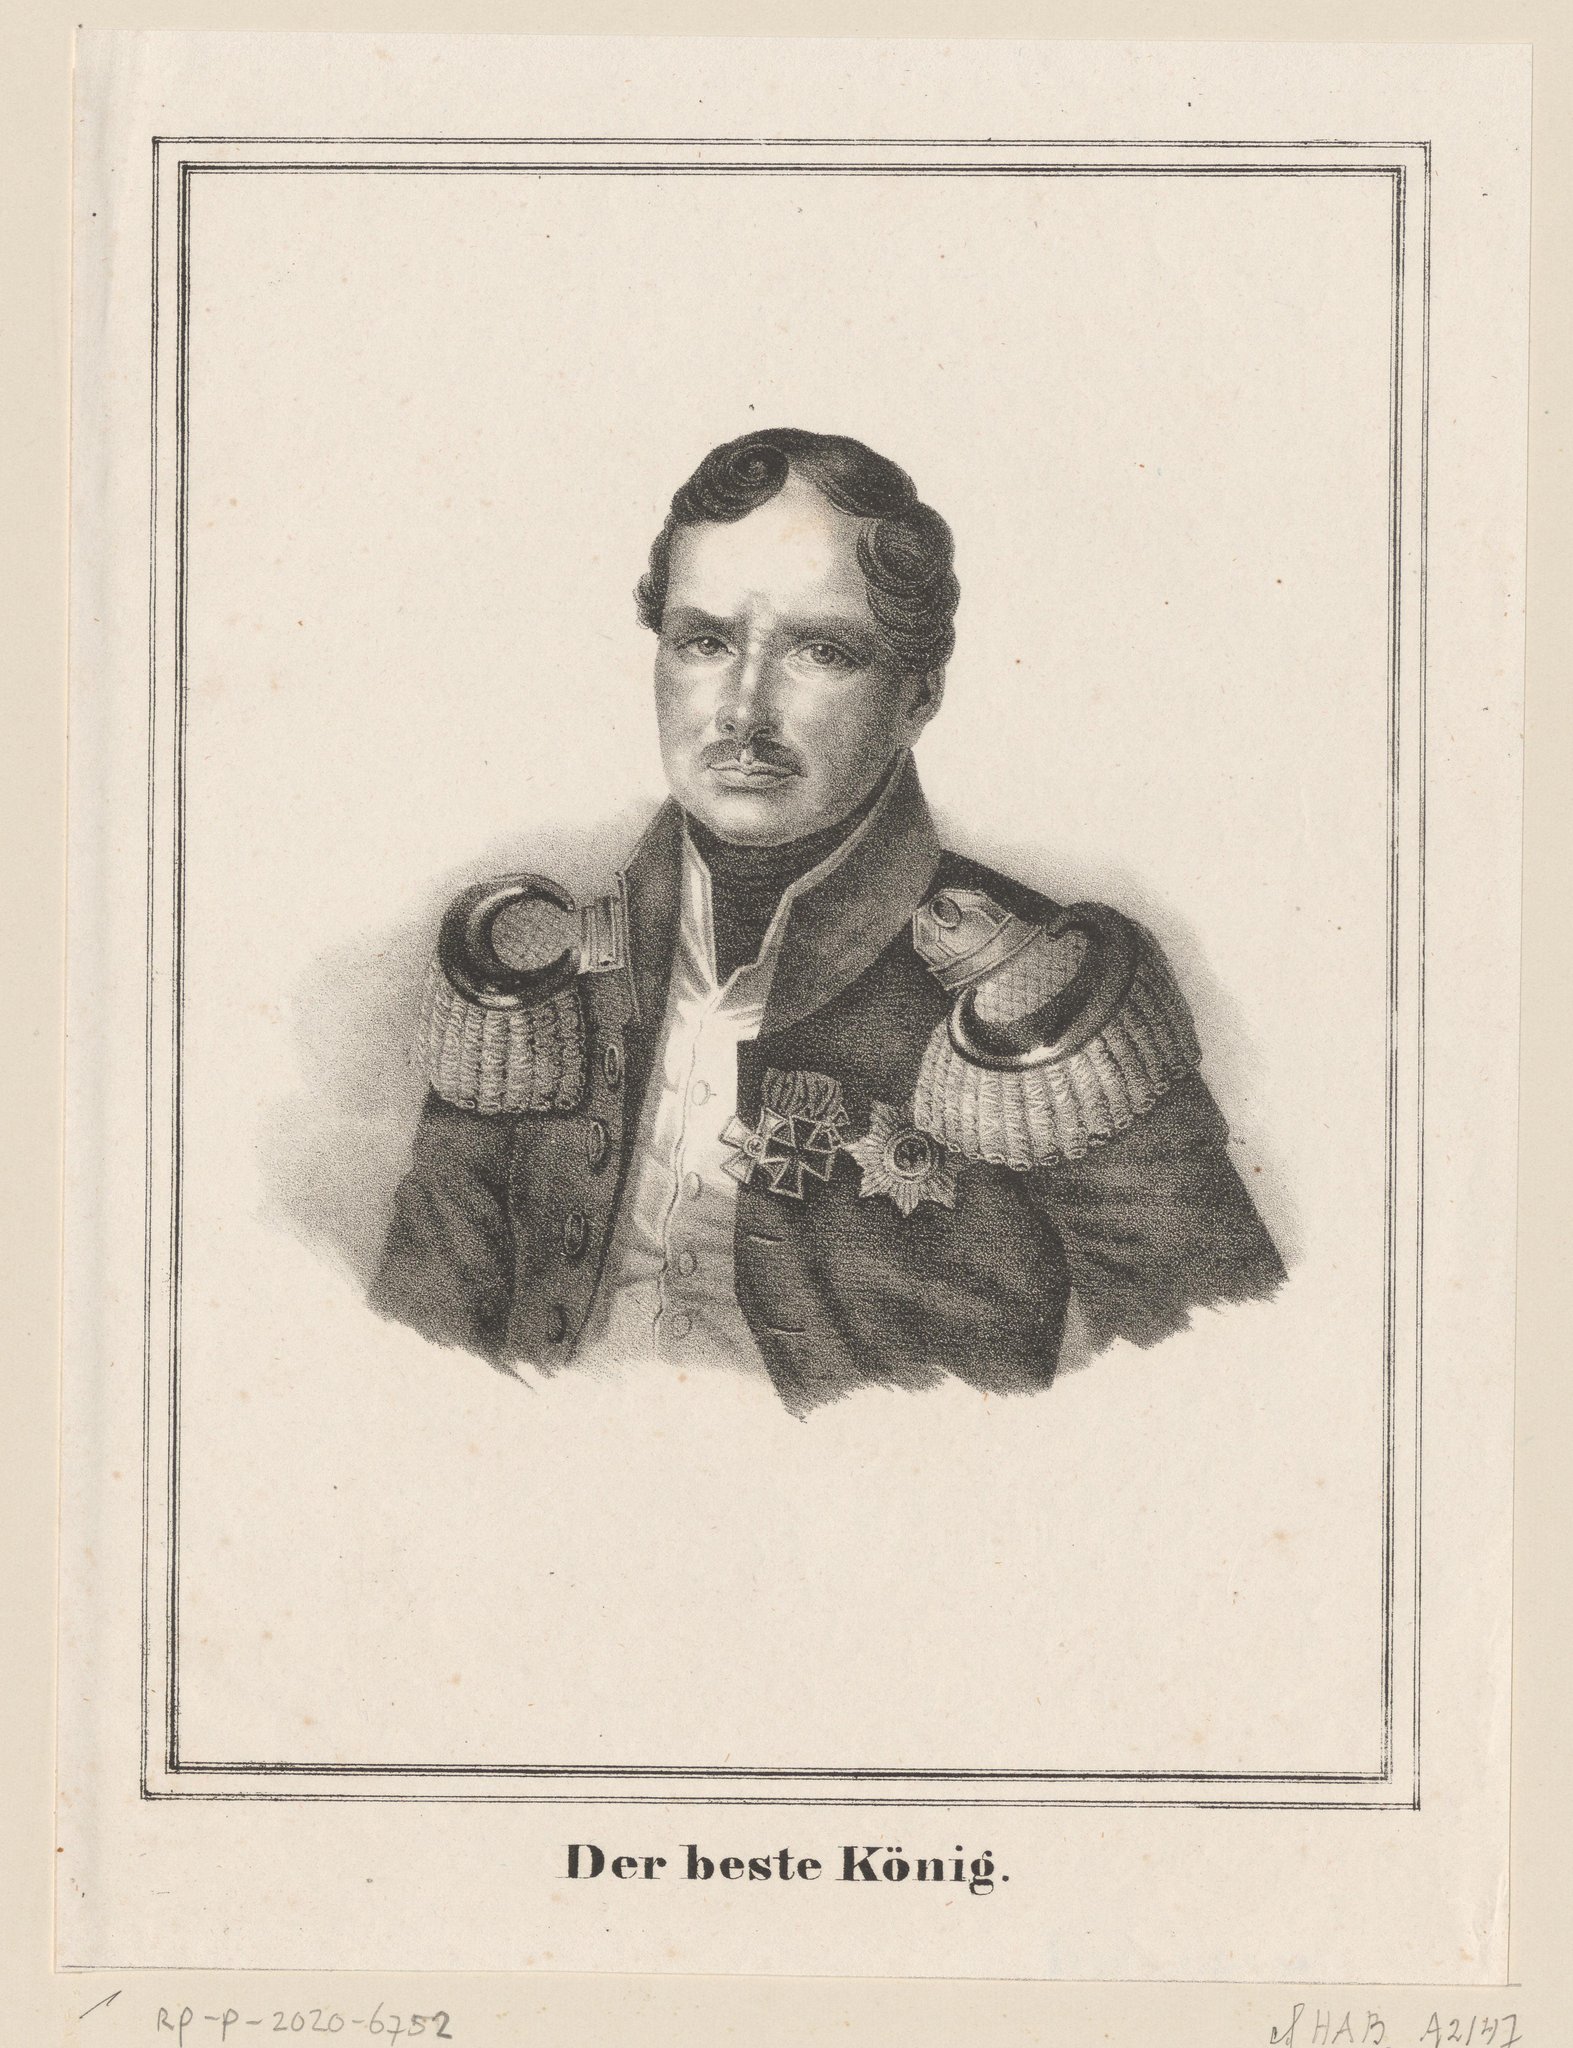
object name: print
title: Portret van Frederik Willem III van Pruisen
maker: Anonymous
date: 1800-1850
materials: paper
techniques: lithograph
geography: germany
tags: berlin, frederik willem iii koning van pruisen, historical persons, (military) uniforms, king